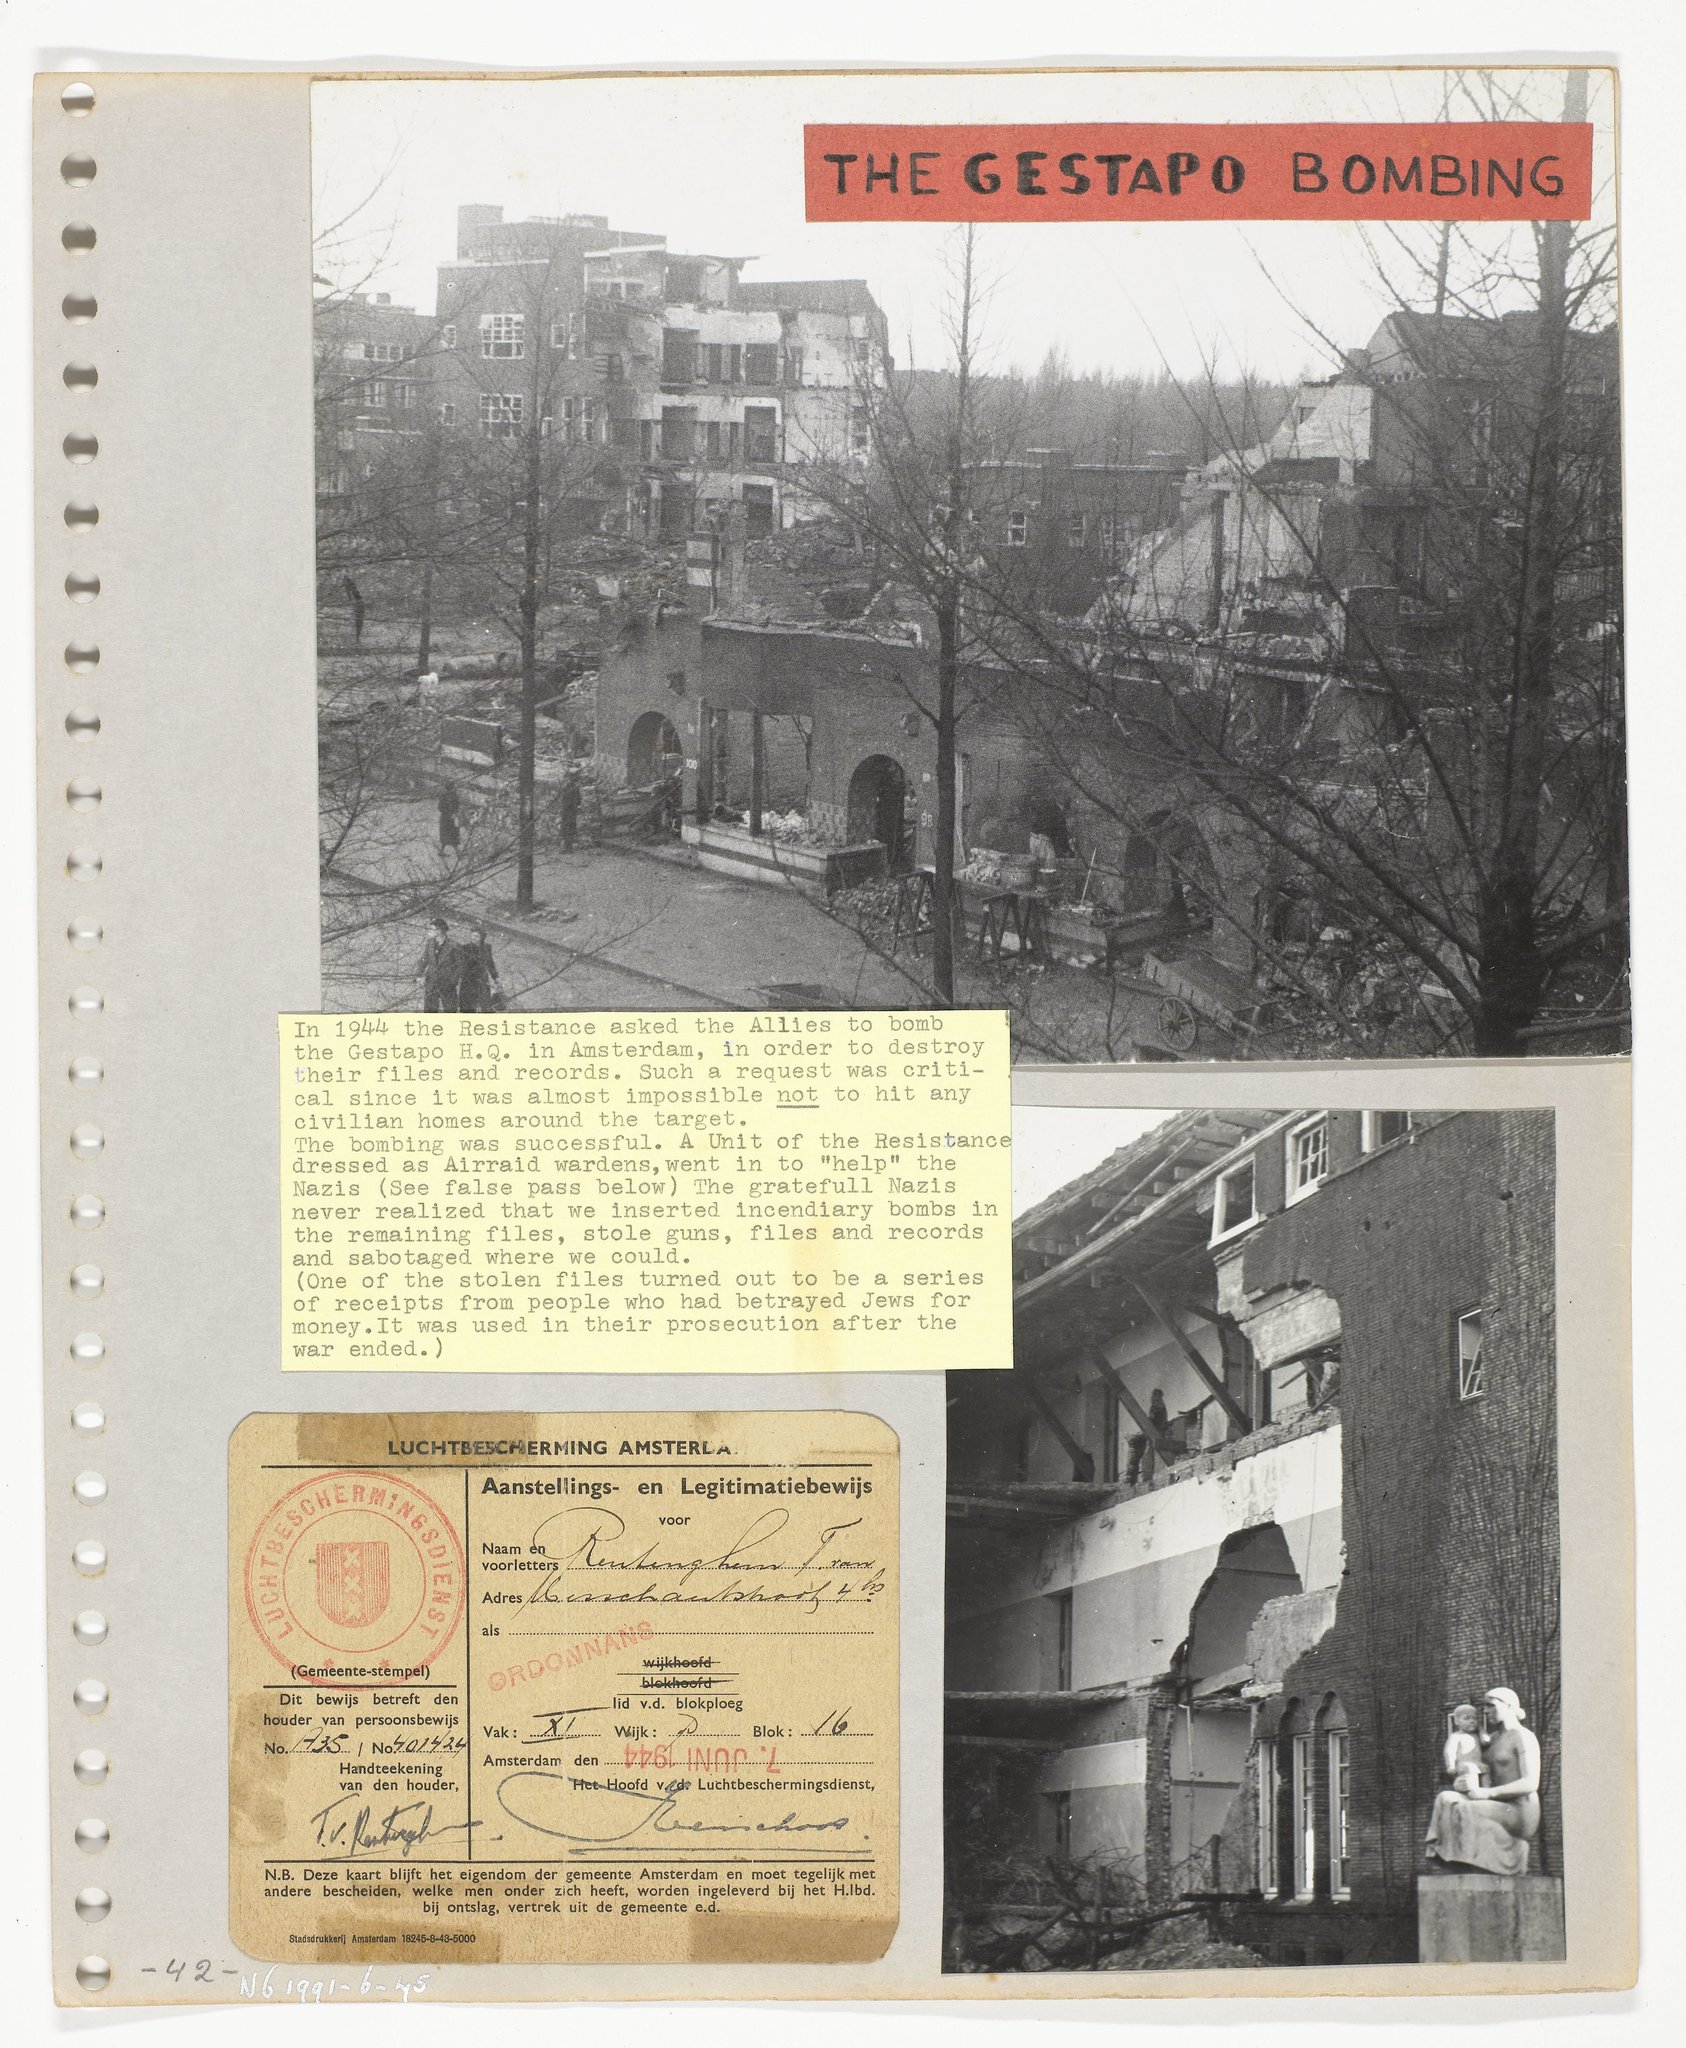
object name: document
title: Foto en collageboek 'De Verborgen Camera'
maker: Anonymous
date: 1911-1944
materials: paper, plastic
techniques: photography, printing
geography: amsterdam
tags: amsterdam, tonny van renterghem, berlin, fritz kahlenberg, passport, visa, underground movement, partisans, netherlands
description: Twee foto's van het gebombardeerde hoofdkwartier van de Sicherheitsdienst (SD) in de Euterpestraat, nu Gerrit van der Veen straat, oorspronkelijk de Meisjes HBS. Valse identiteitskaart van T. van Renterghem van de Luchtbeschermingsdienst, waarmee hij het hoofdkwartier binnenkwam na het bombardement en brandbommen plaatste.